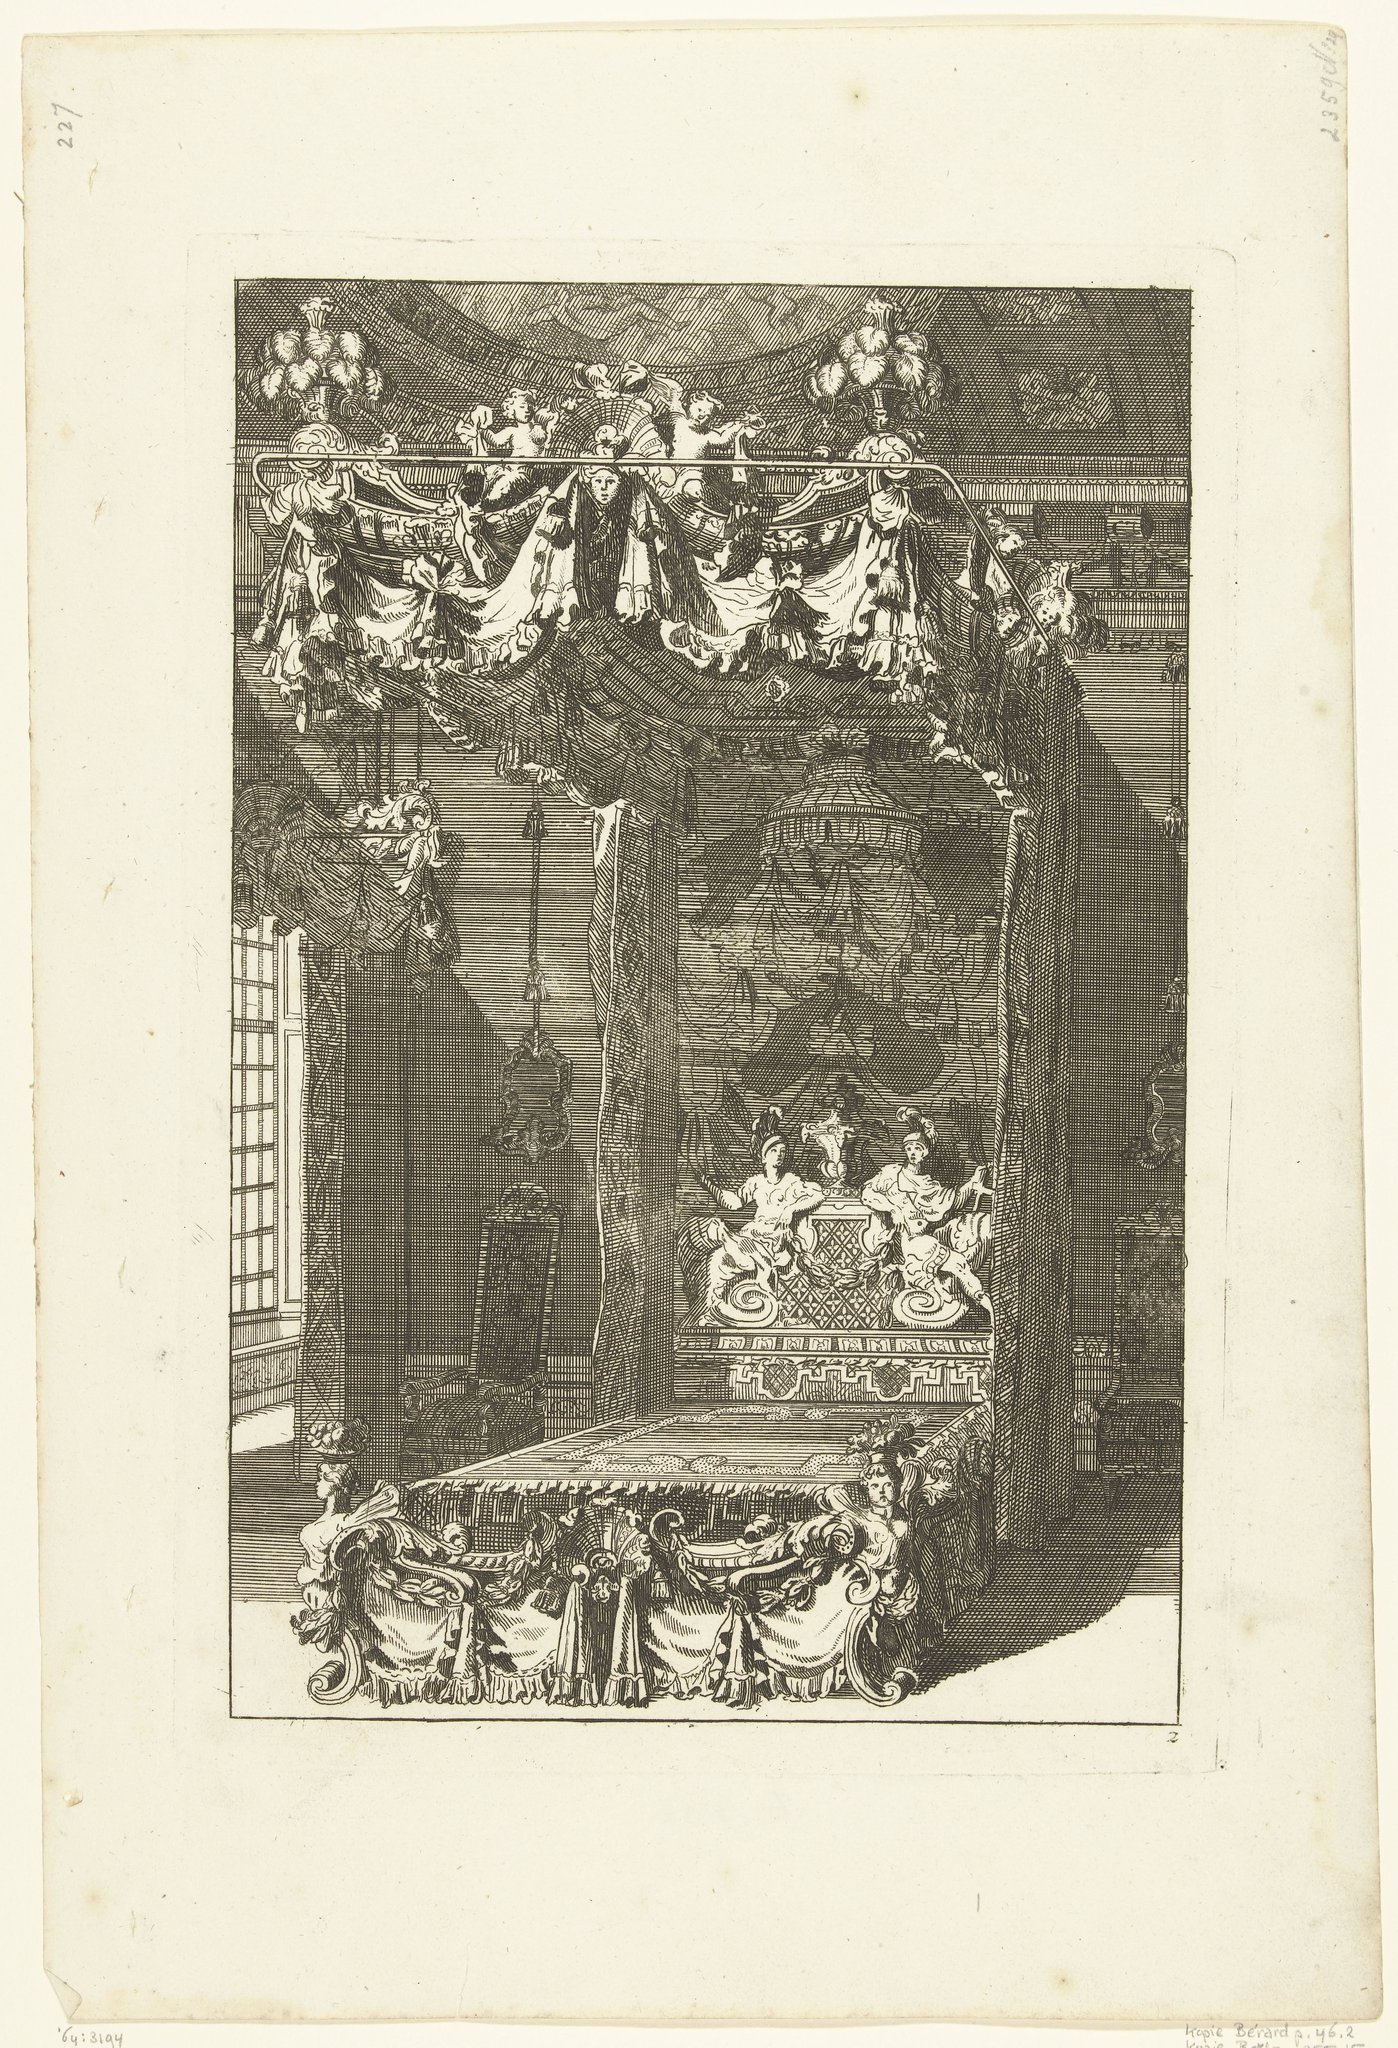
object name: ornament print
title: Liure dappartement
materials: paper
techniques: etching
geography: netherlands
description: Links is een raam te zien door een open deur. Het hoofd van het bed is gedecoreerd met twee soldaten. Tegenzijdige kopie naar blad uit de serie Second Liure Dappartements.